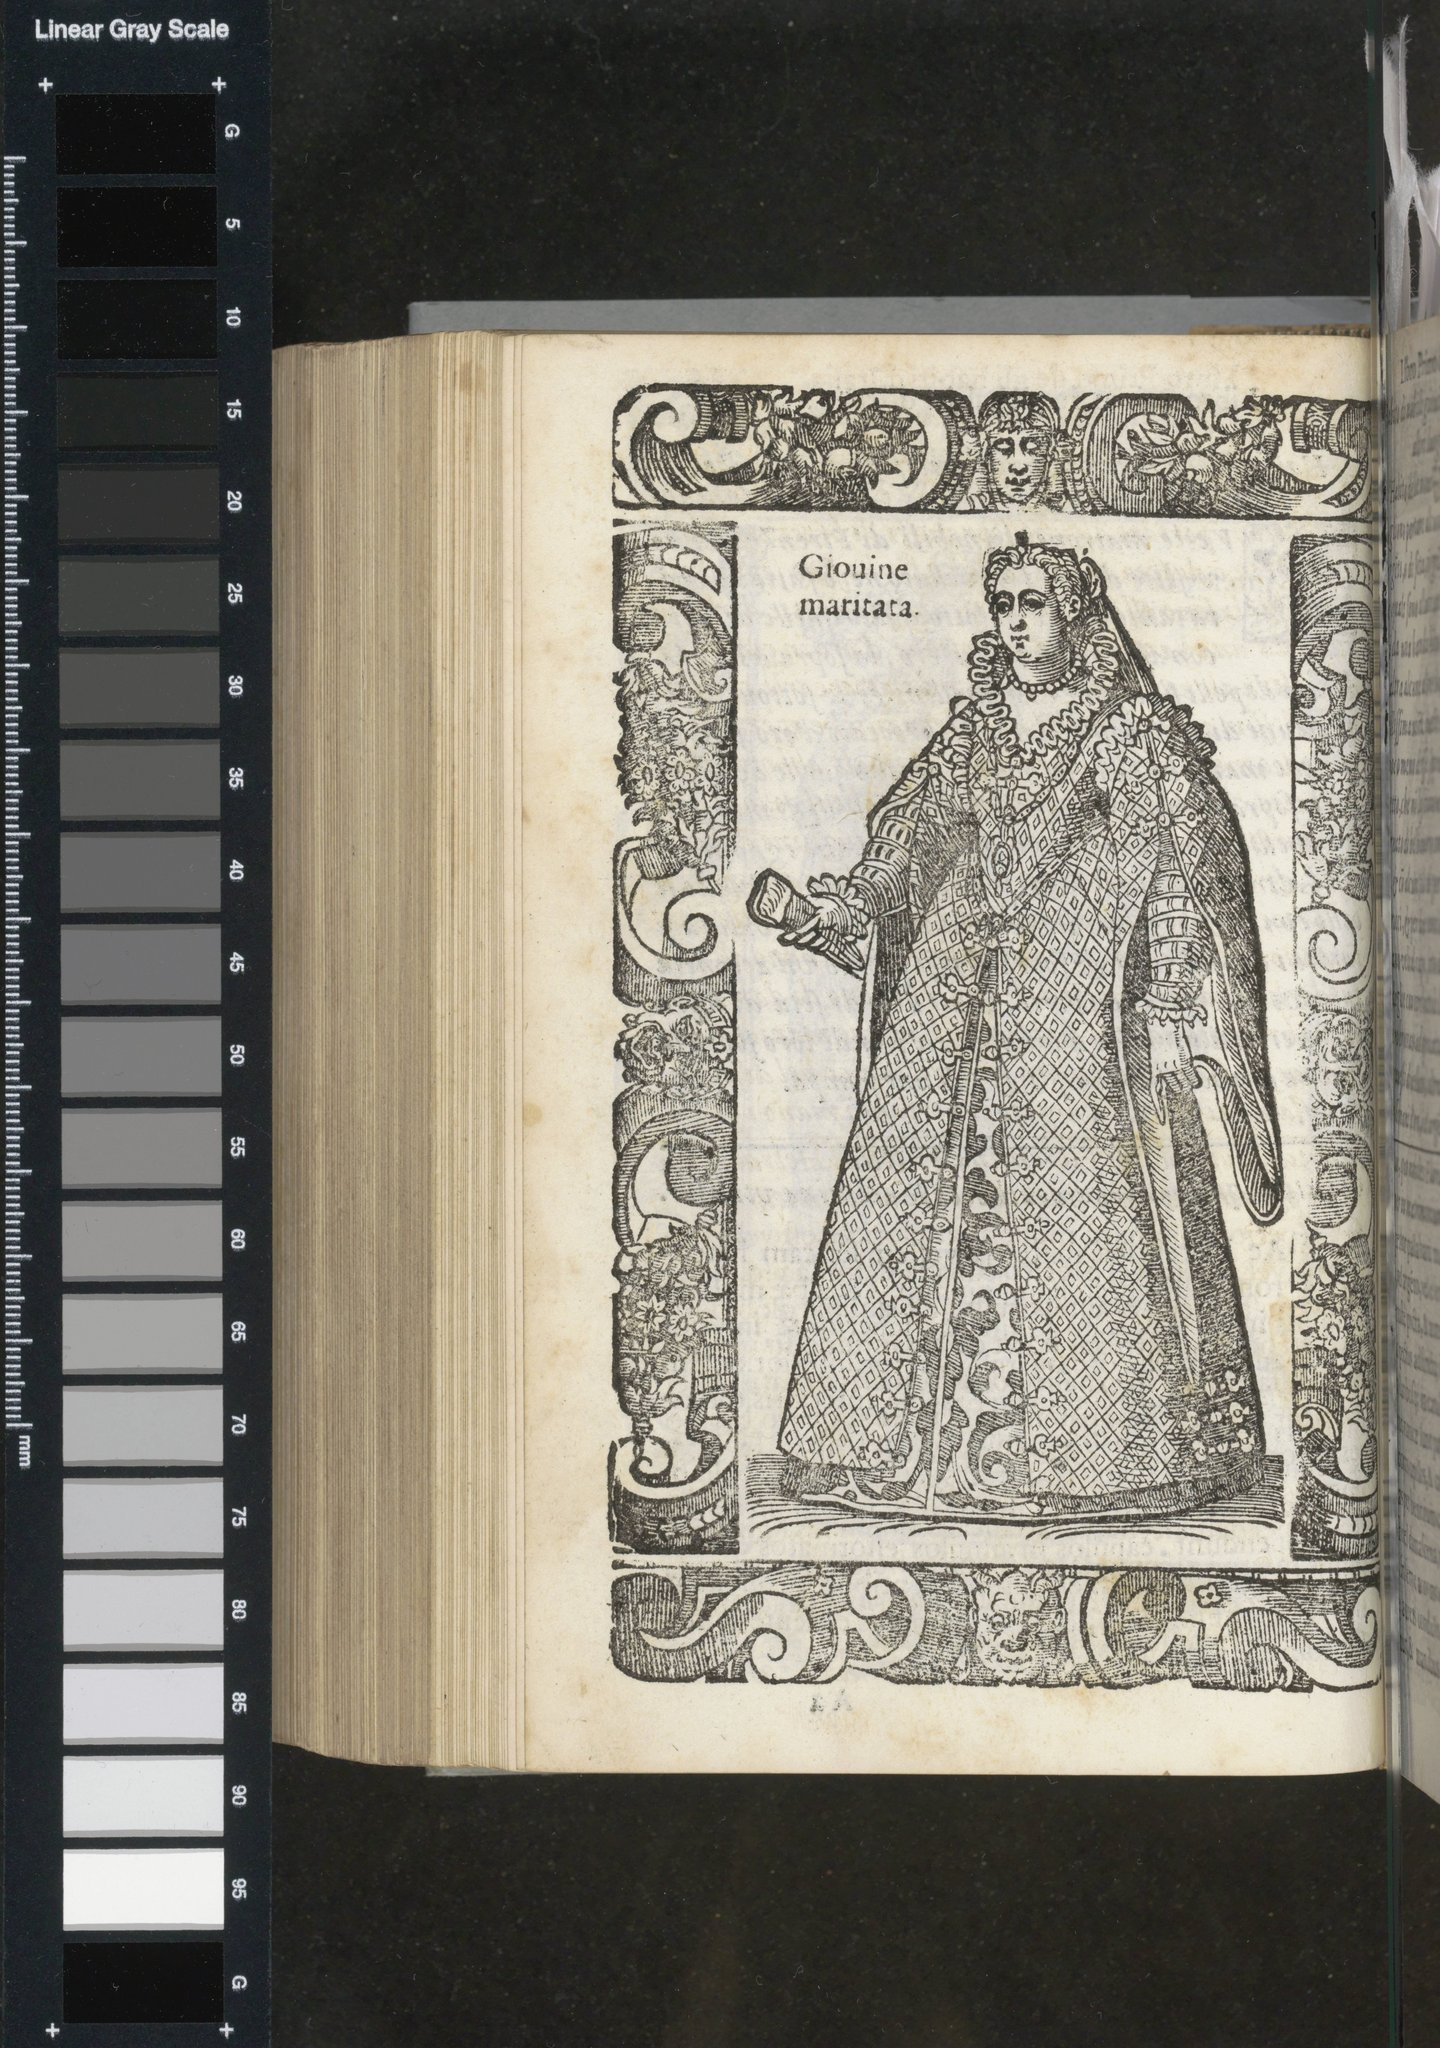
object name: costume print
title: Habiti antichi, et moderni di tutto il mondo...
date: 1598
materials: paper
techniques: woodcut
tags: veil (+ women's clothes), dress, gown (fartingale) (+ women's clothes), fashion plates, gloves, mittens, etc. (+ women's clothes), dress, gown (+ women's clothes), pearl; pearl necklace (+ women's clothes)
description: Pas getrouwde adellijke dame in Florence in een overkleed van goud- of zilverbrokaat zijde, tot net boven de voet, aan de voorkant vastgezet met gouden 'haken en ogen', met open mouwen. Hieronder een onderkleed met 'faldiglie' (fardegalijn) . Handschoenen in de hand.